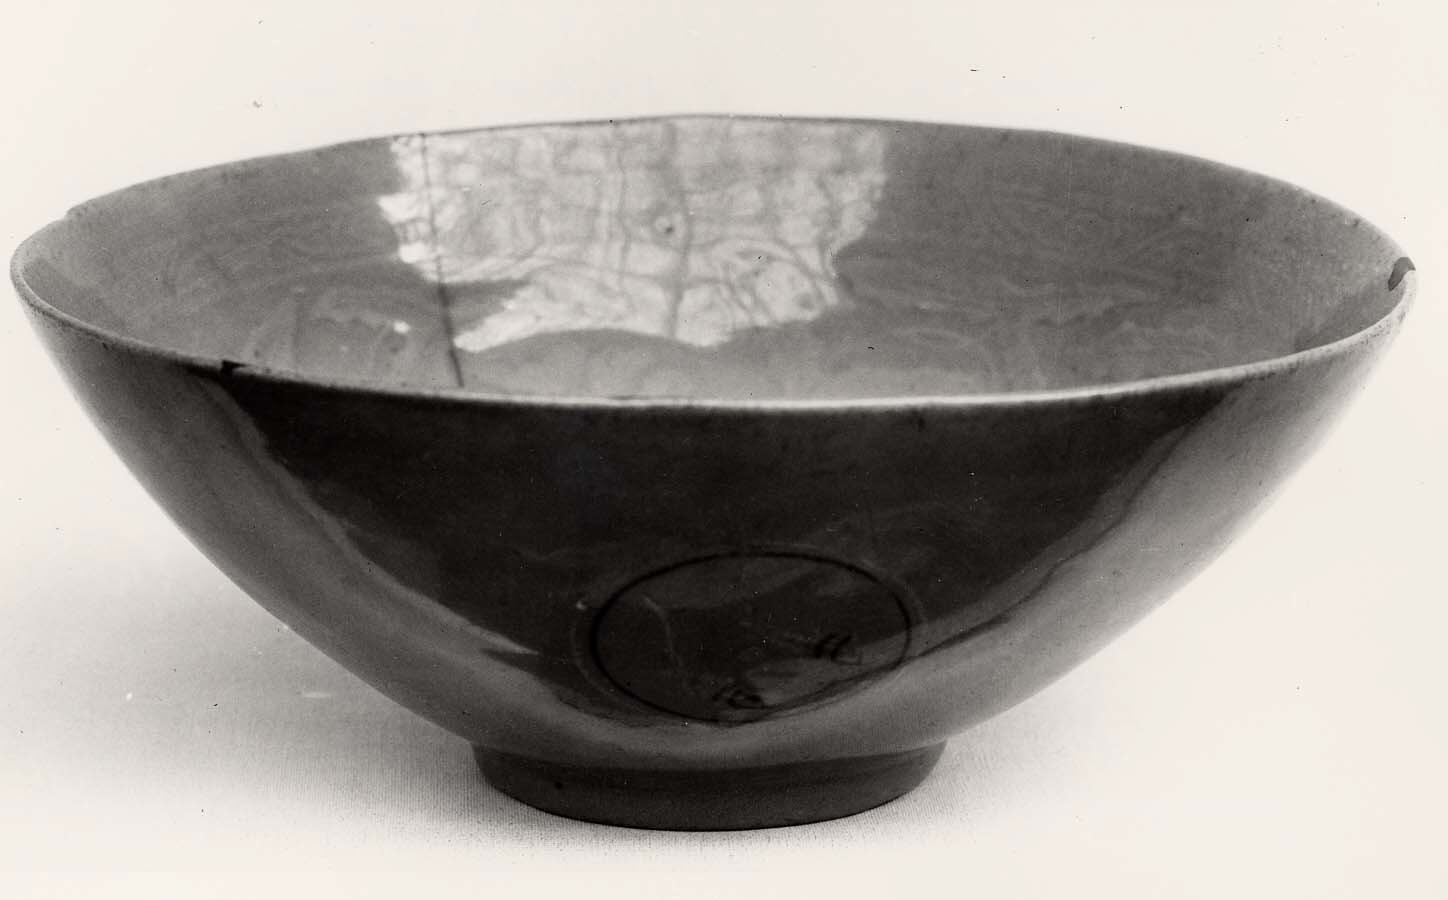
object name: bowl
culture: korean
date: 1134-1166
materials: ceramic glaze, glaze, stoneware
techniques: inlay, relief